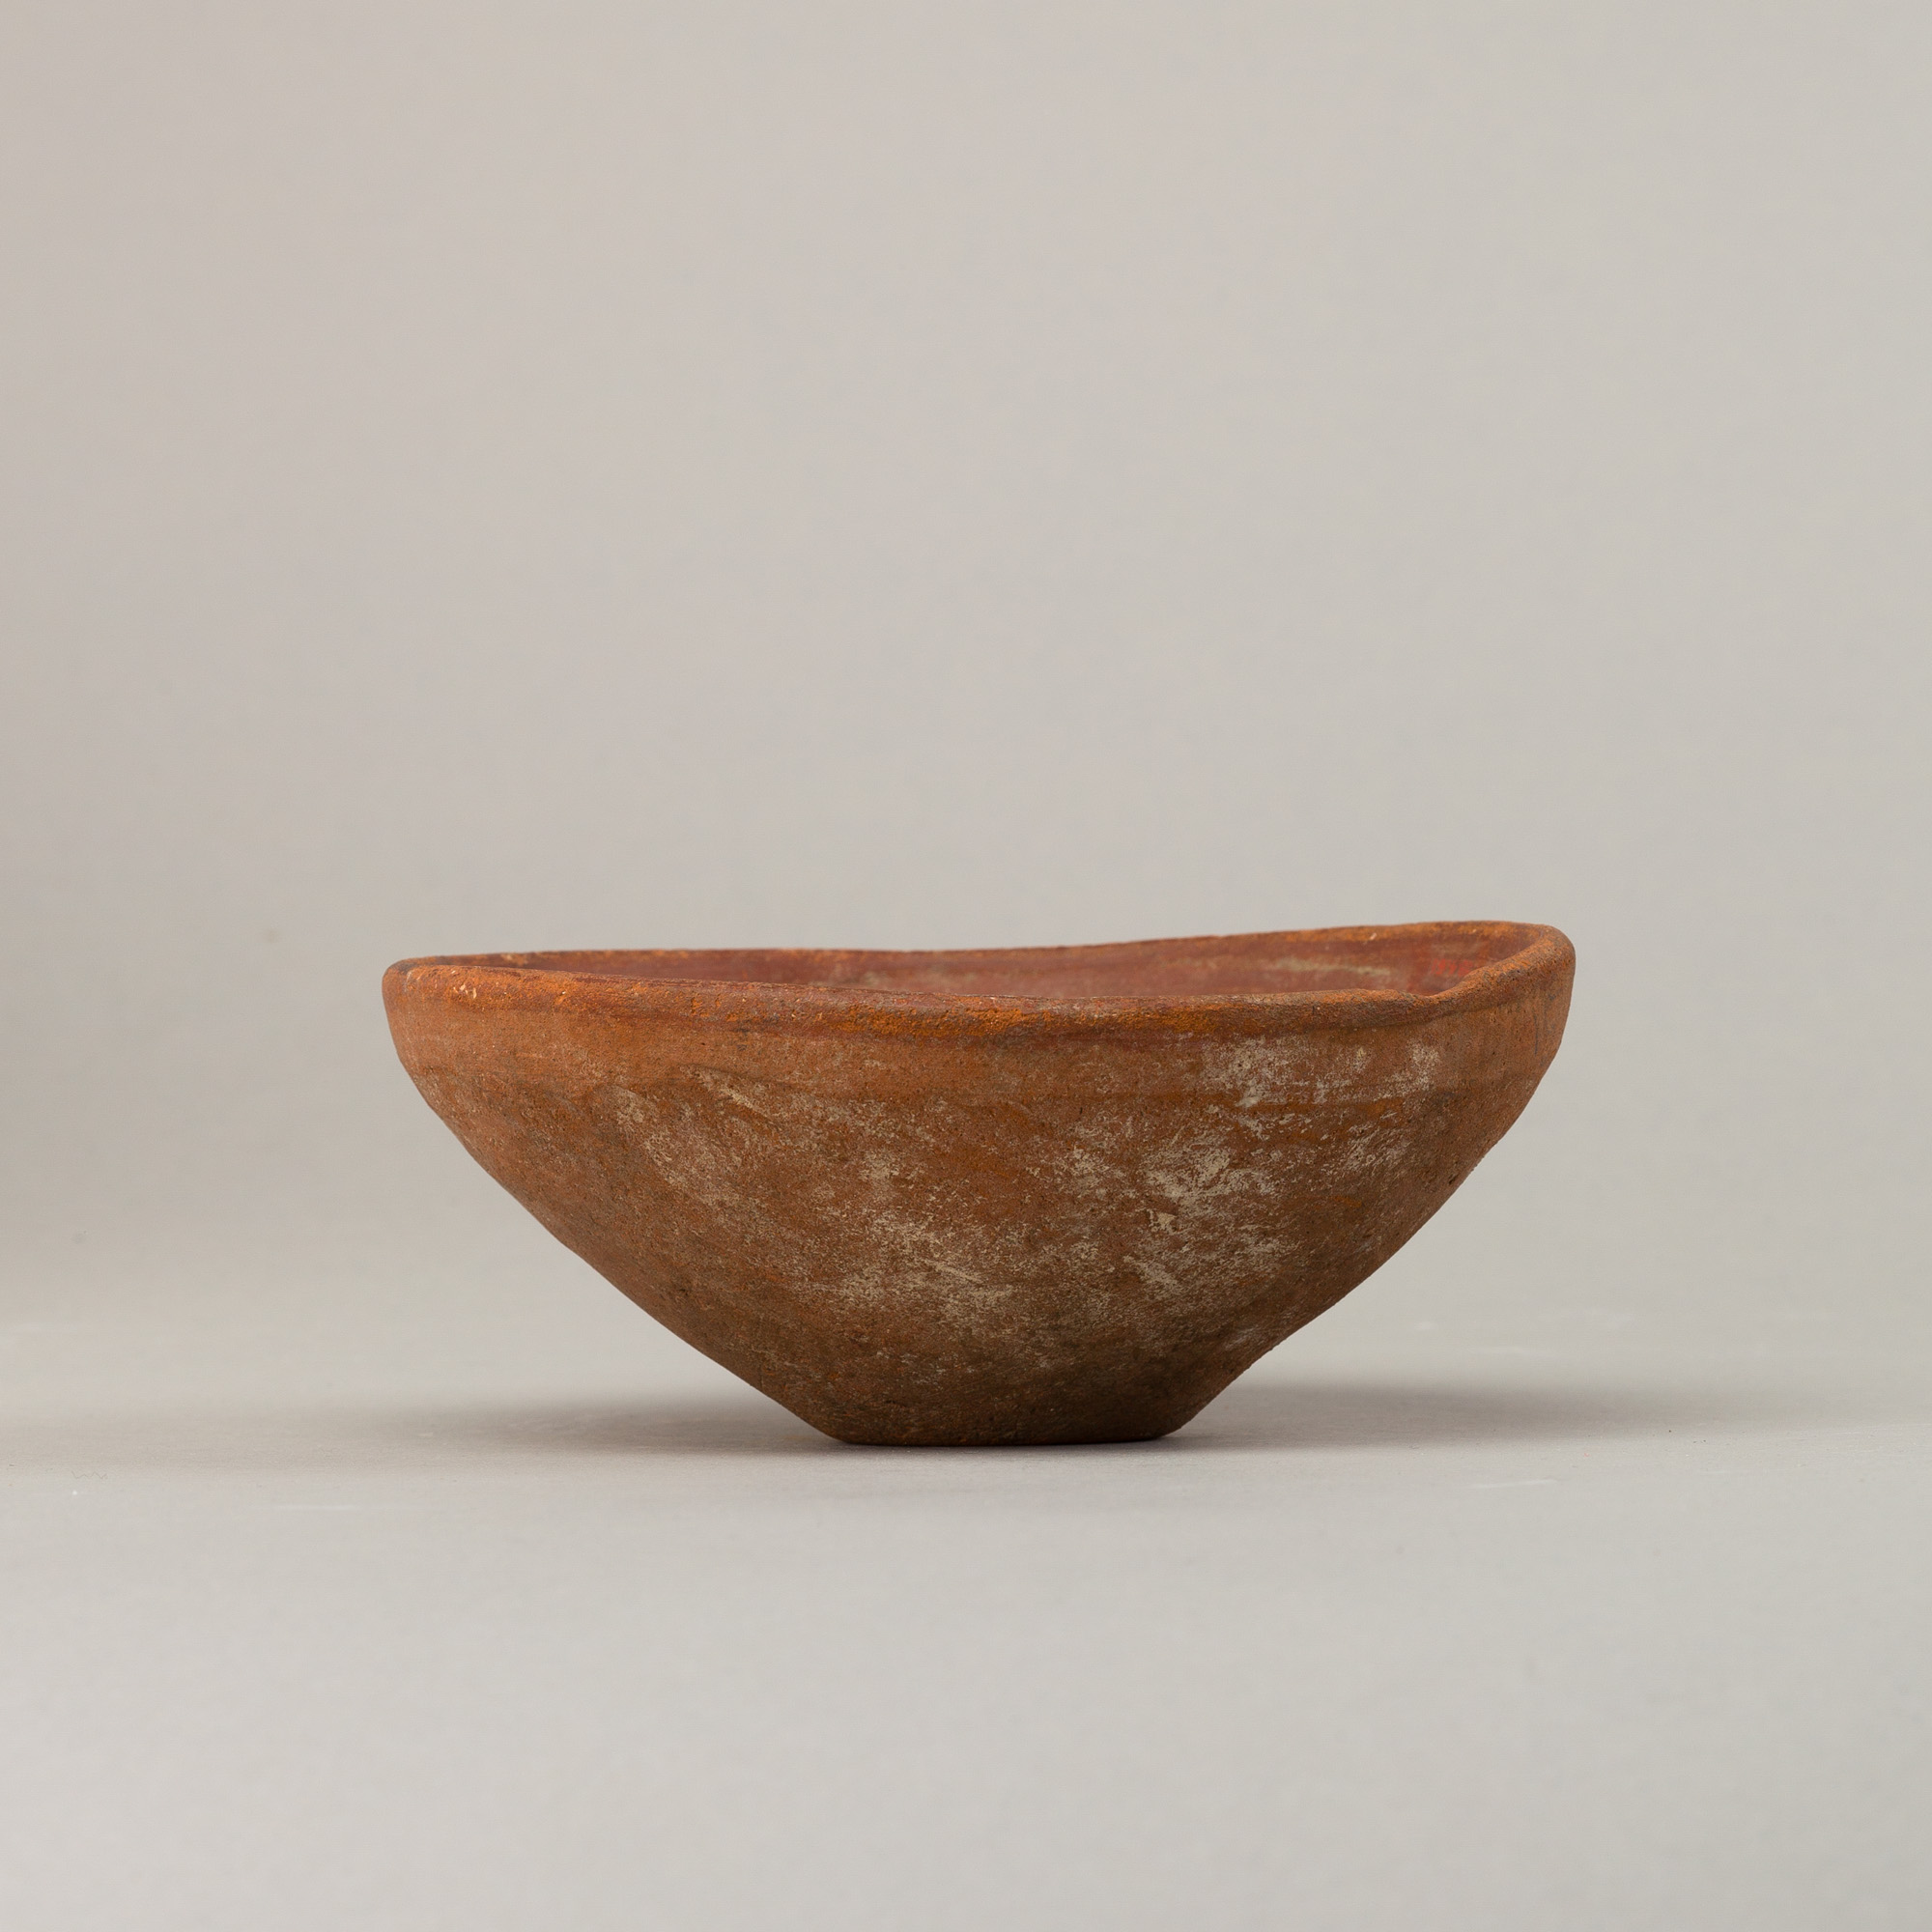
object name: bowl, shallow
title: Shallow bowl with vertical rim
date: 3850-2960 BCE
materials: pottery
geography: egypt